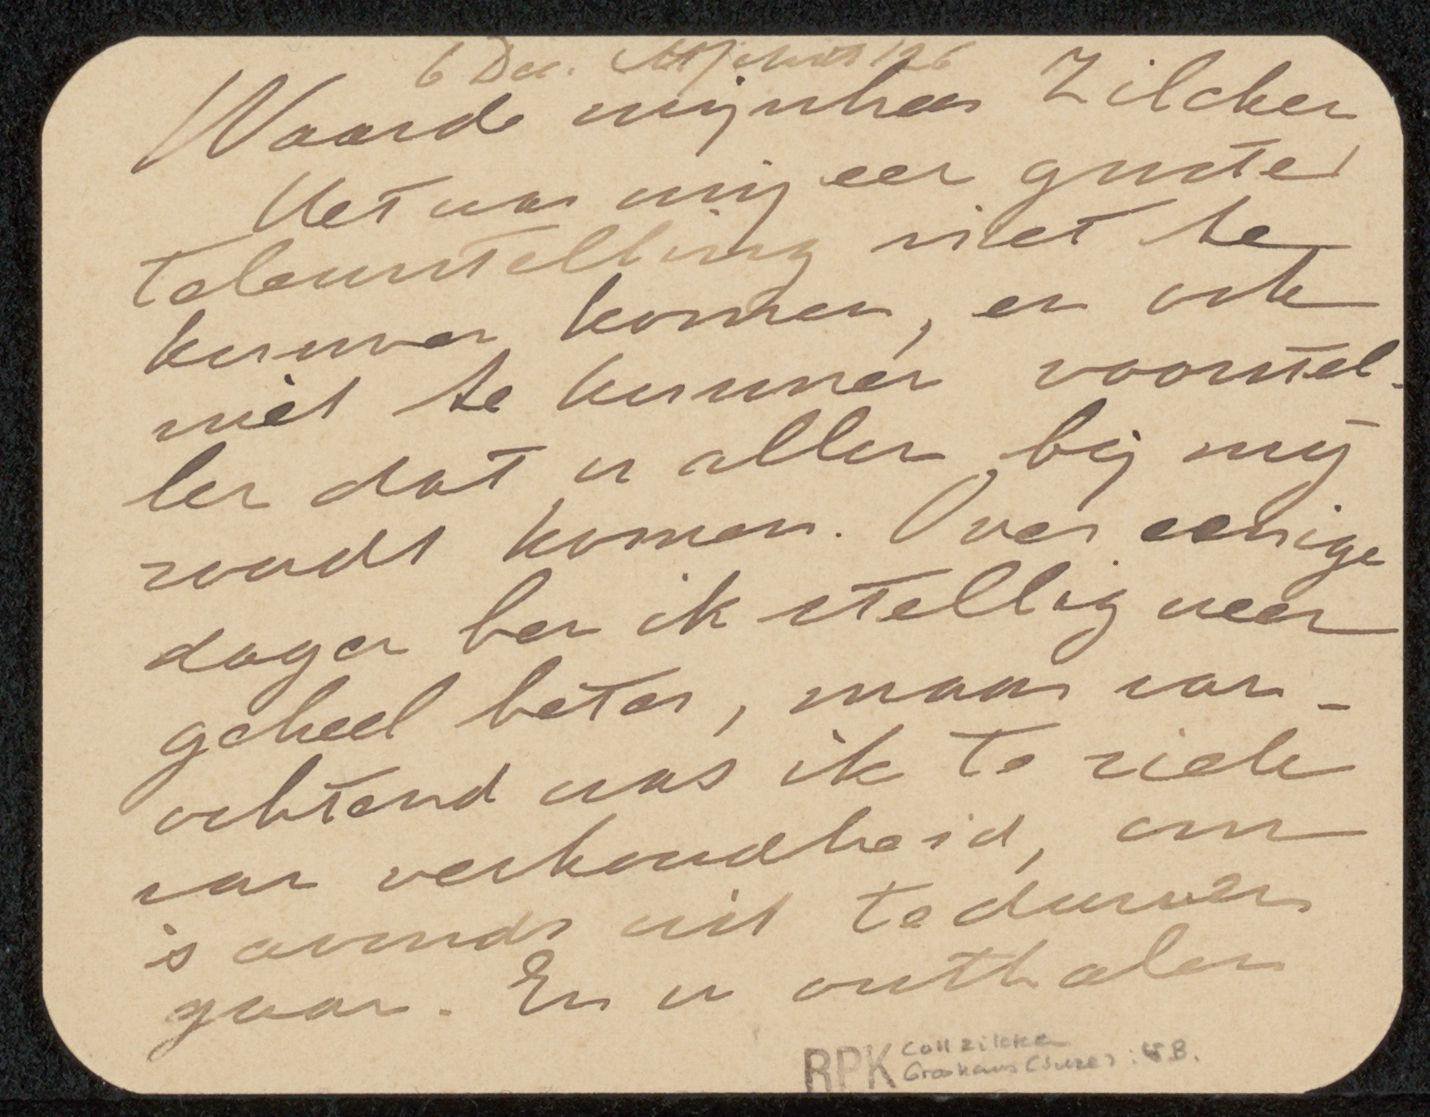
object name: letter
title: Brief aan Philip Zilcken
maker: suze groshans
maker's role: schrijver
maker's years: 1863-1944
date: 1926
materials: cardboard, ink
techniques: pen, writing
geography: the hague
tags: painter, draughtsman, philip zilcken, diseases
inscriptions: collector's mark: ‘RPK’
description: Vormt samen met RP-D-1982-43-GROSHANS(SUZE)-5C een doorlopende brief.